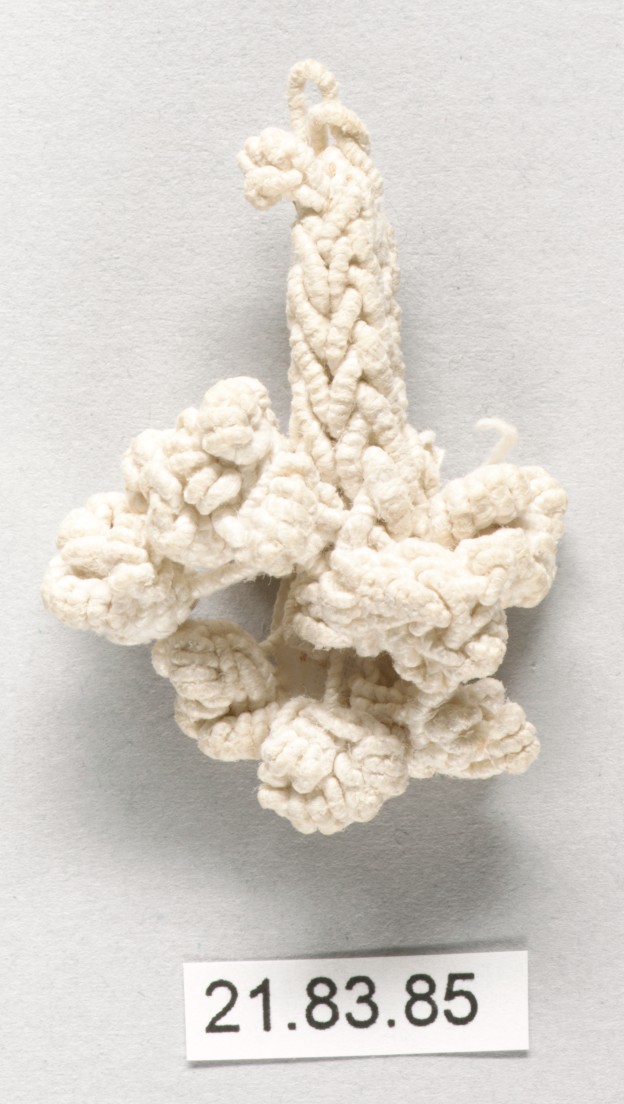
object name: tassel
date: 1601-1700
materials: linen